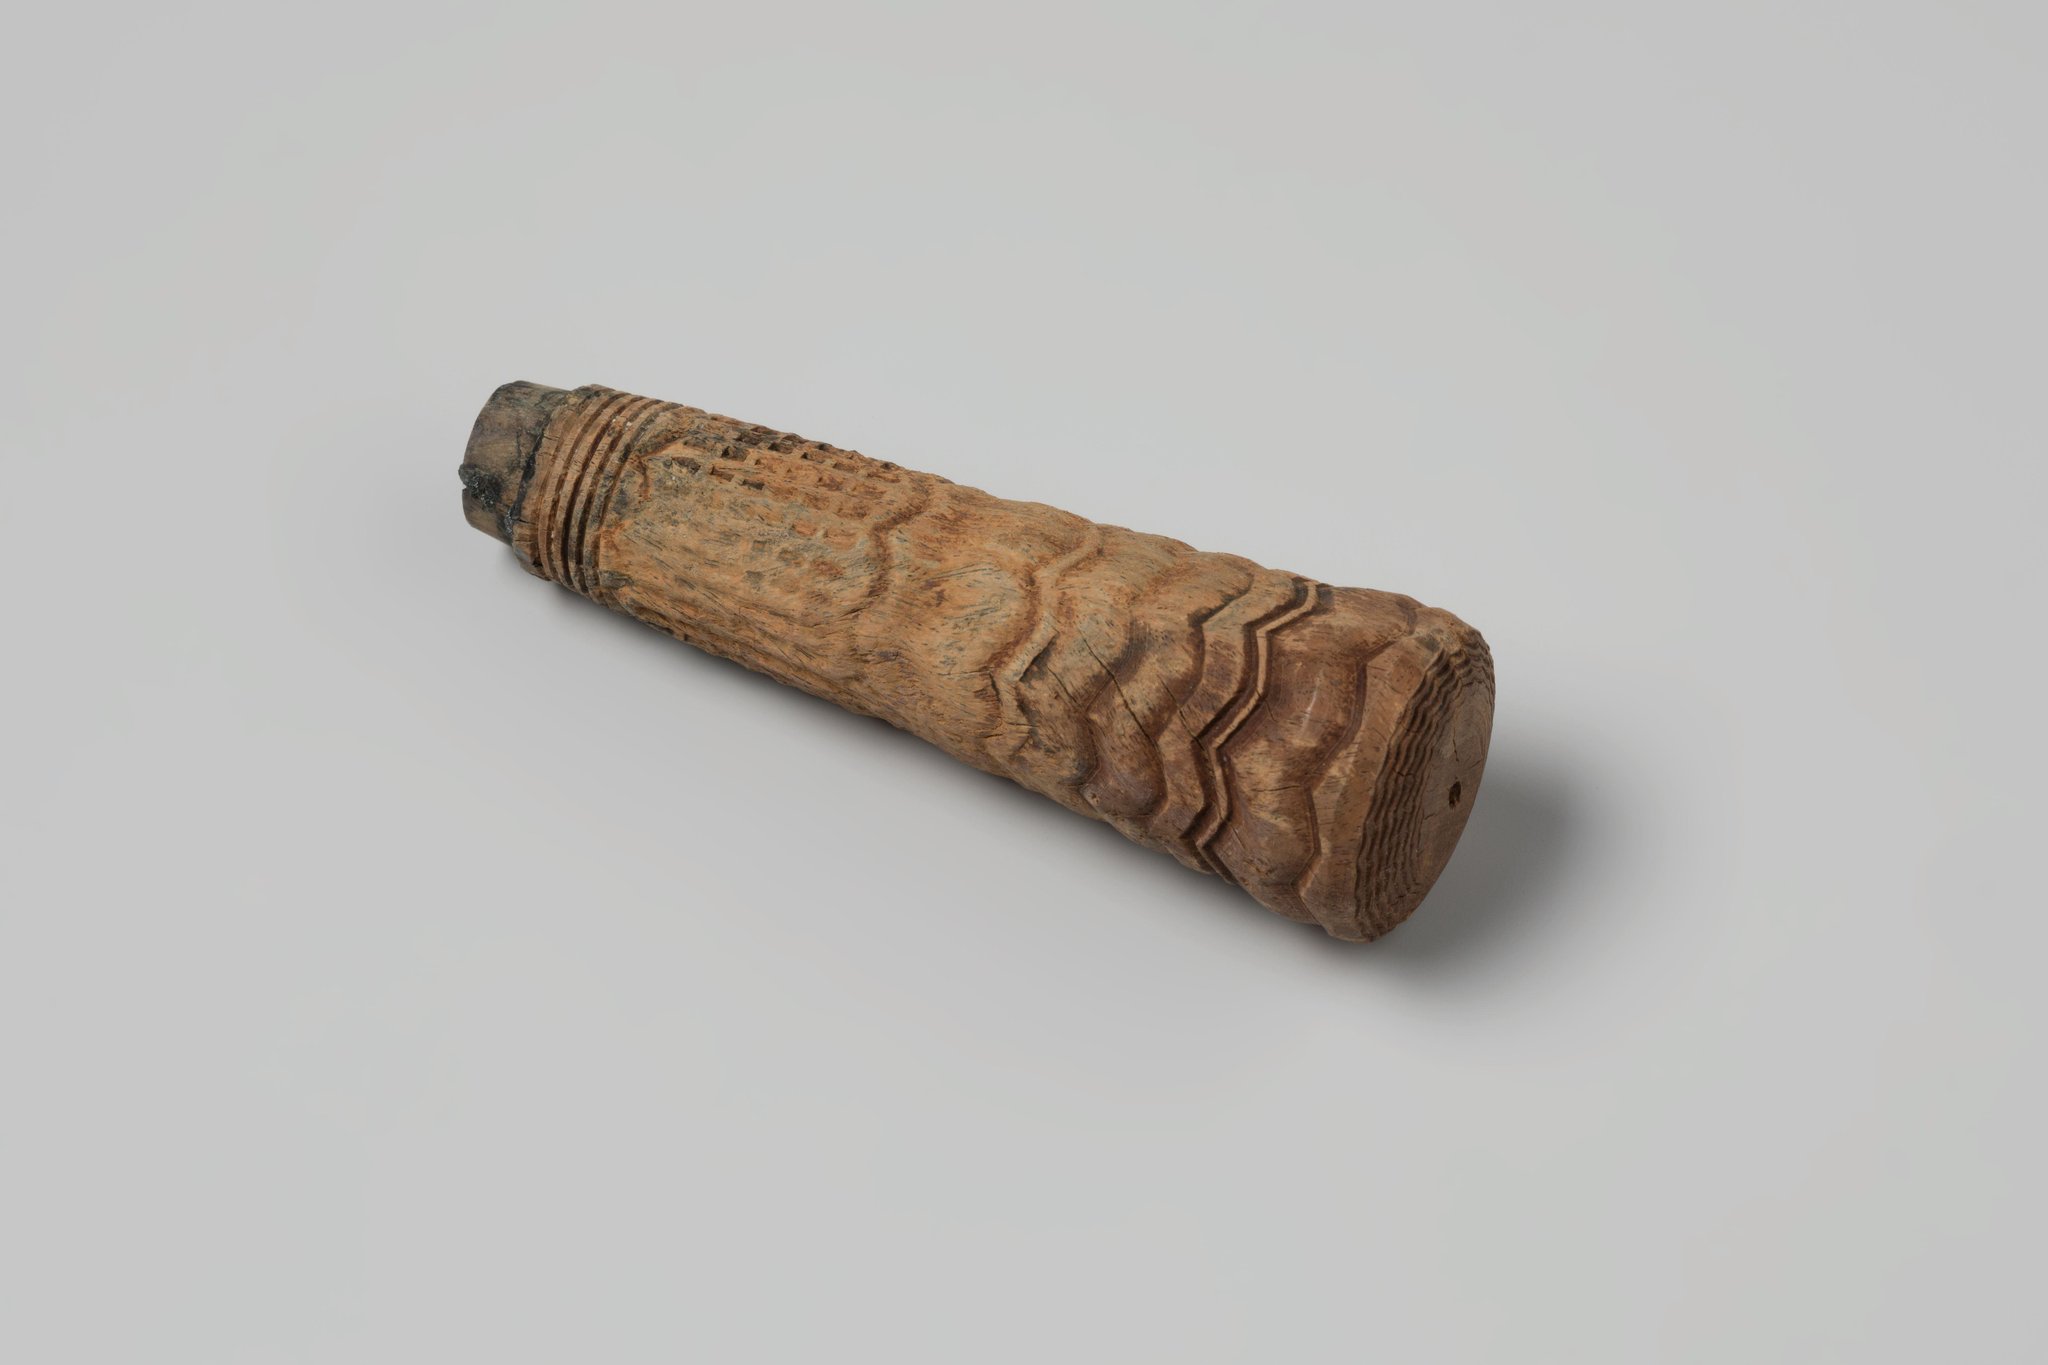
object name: knife handle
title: Messenheft uit het wrak van de Oost-Indiëvaarder Hollandia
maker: Anonymous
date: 1700-1743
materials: wood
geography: netherlands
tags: verenigde oostindische compagnie, hollandia (schip), annet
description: Knife, handle, cylindrical: tapering; id. NG 1980-27H1364.